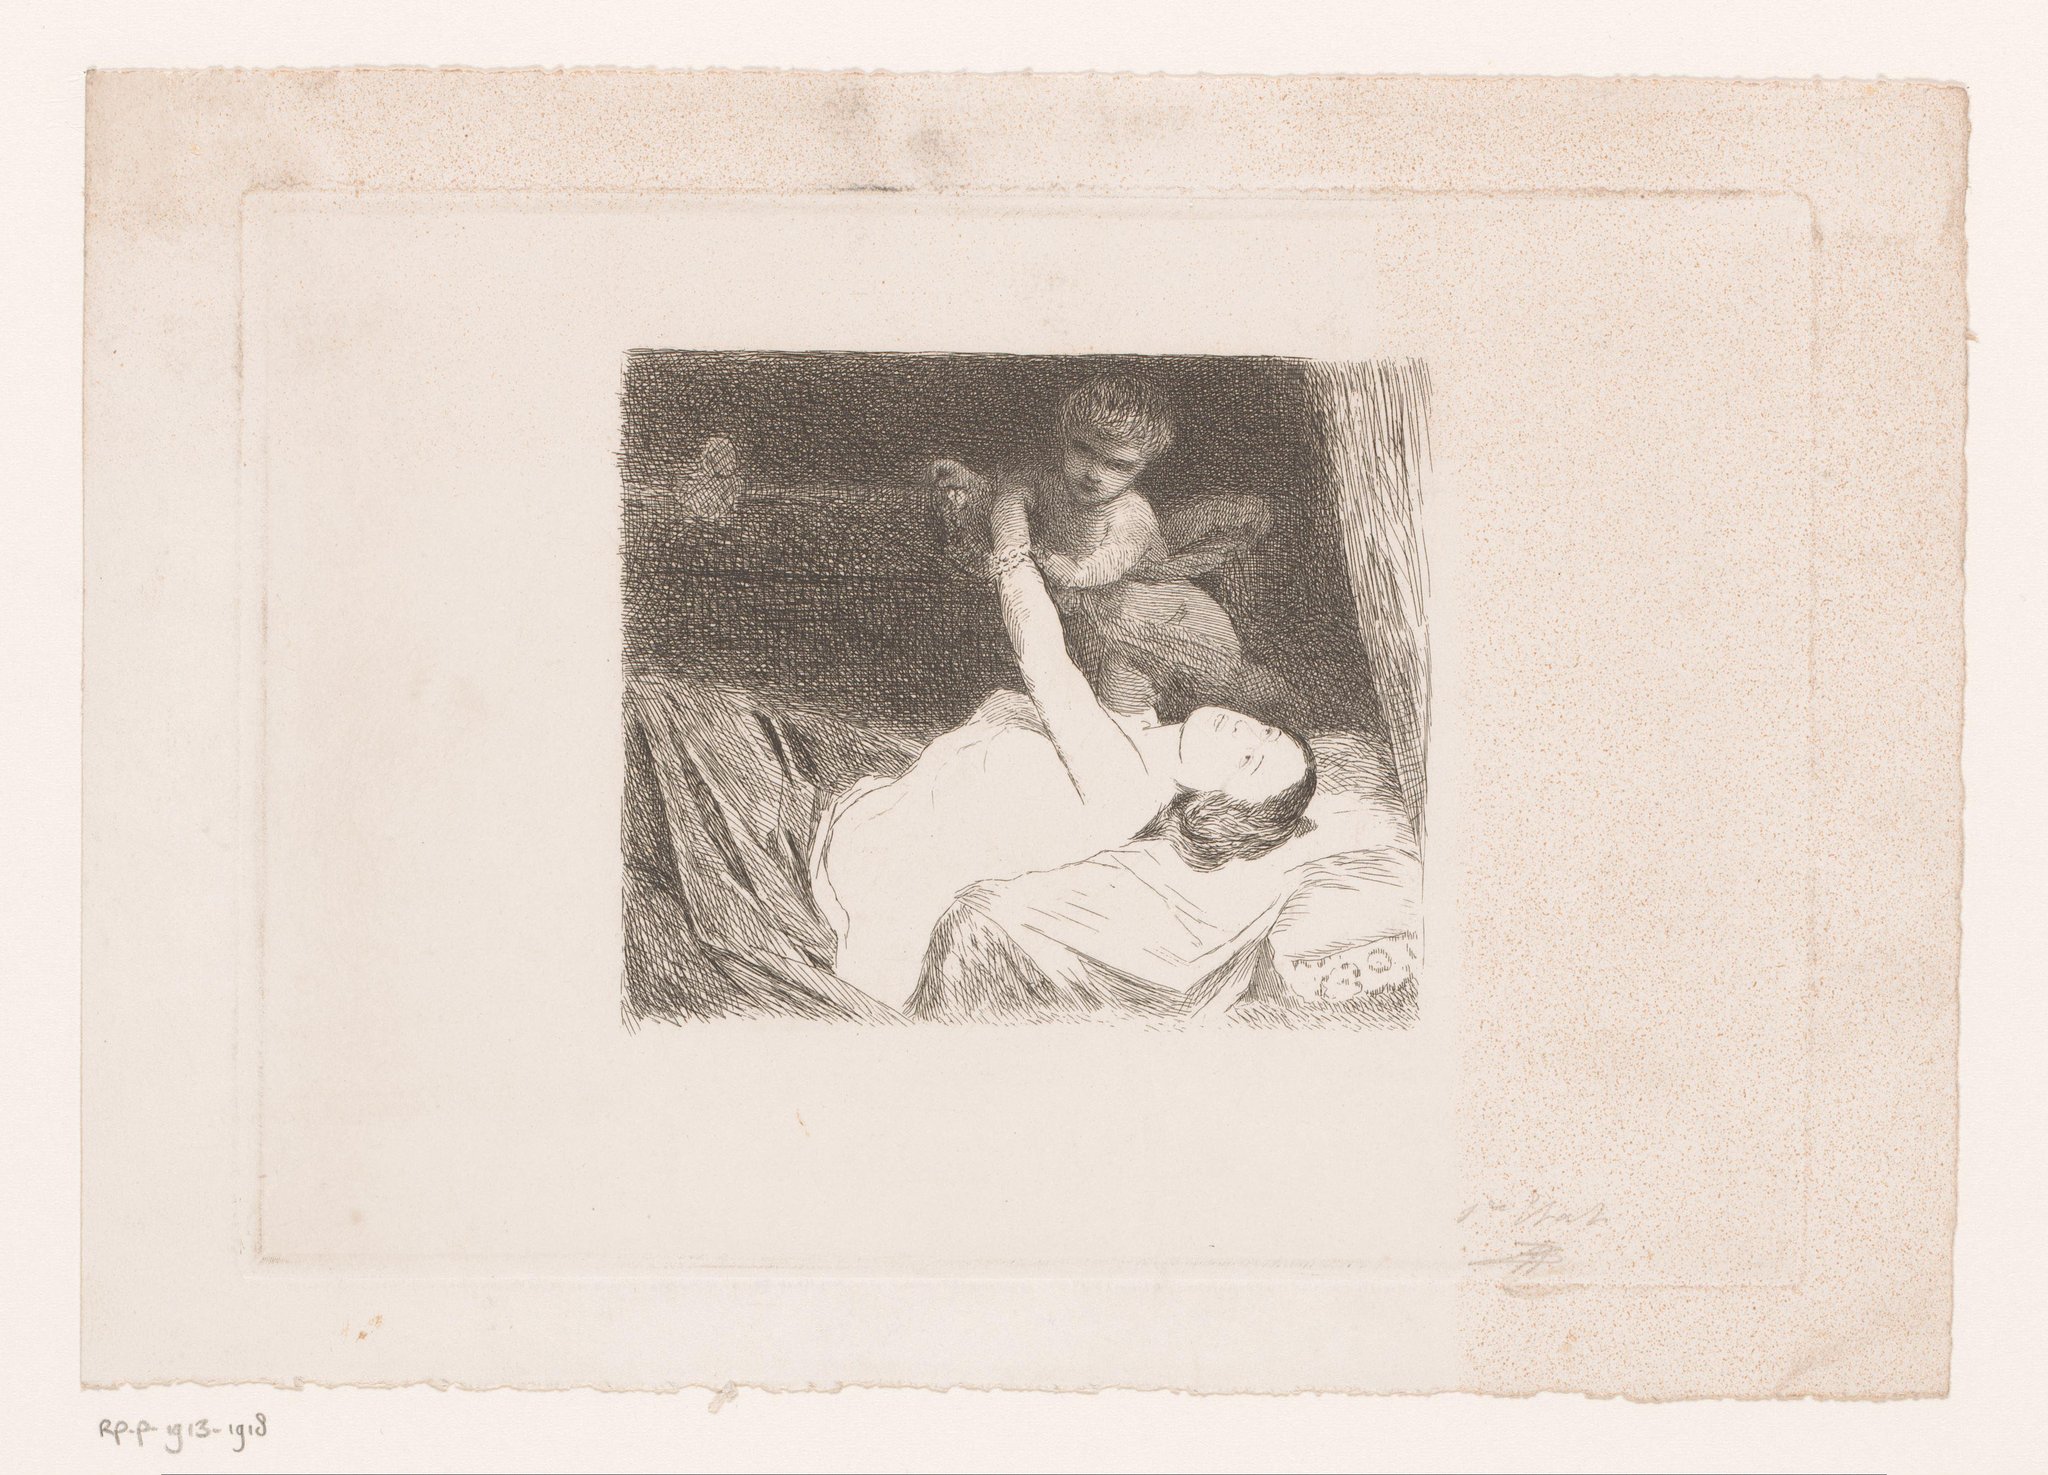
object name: print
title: Jonge vrouw en kind op bed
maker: jean baptiste pierre michiels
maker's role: print maker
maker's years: 1821-1890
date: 1831-1890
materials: paper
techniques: etching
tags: adolescent, young woman, maiden, mother and baby or young child, the (nude) human figure; 'corpo humano' (ripa) - aa - female human figure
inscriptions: inscription: ‘1e Etat’, collector's mark: Lugt 2228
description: Mogelijk gaat het om een voorstelling van Amor en Psyche.